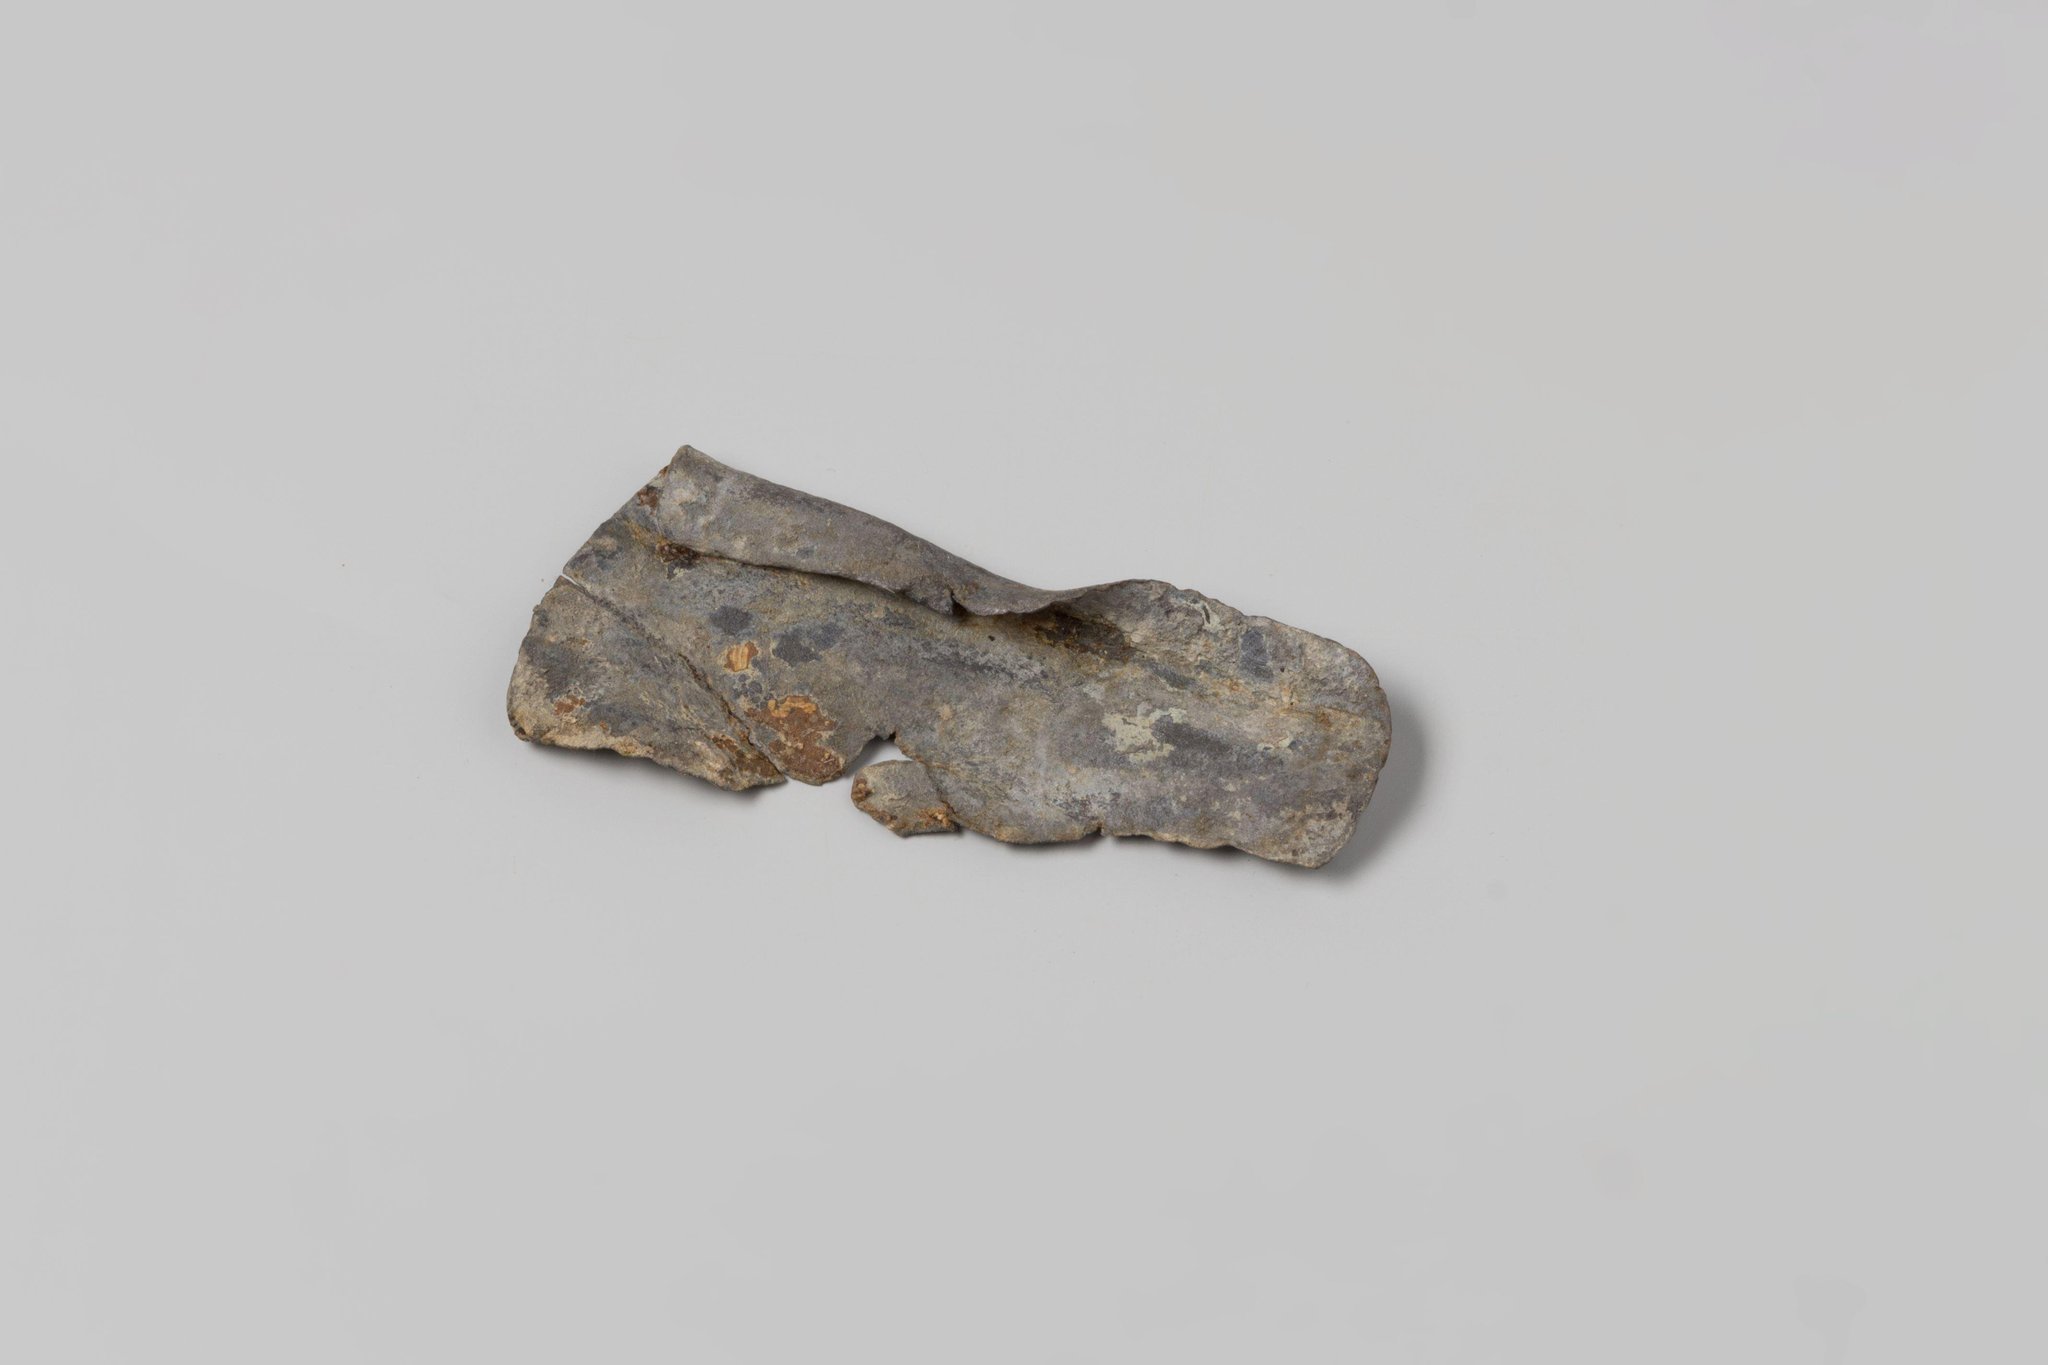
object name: fragment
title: Fragment lood uit het wrak van de Oost-Indiëvaarder Hollandia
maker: Anonymous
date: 1700-1743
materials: lead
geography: netherlands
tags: verenigde oostindische compagnie, hollandia (schip), annet